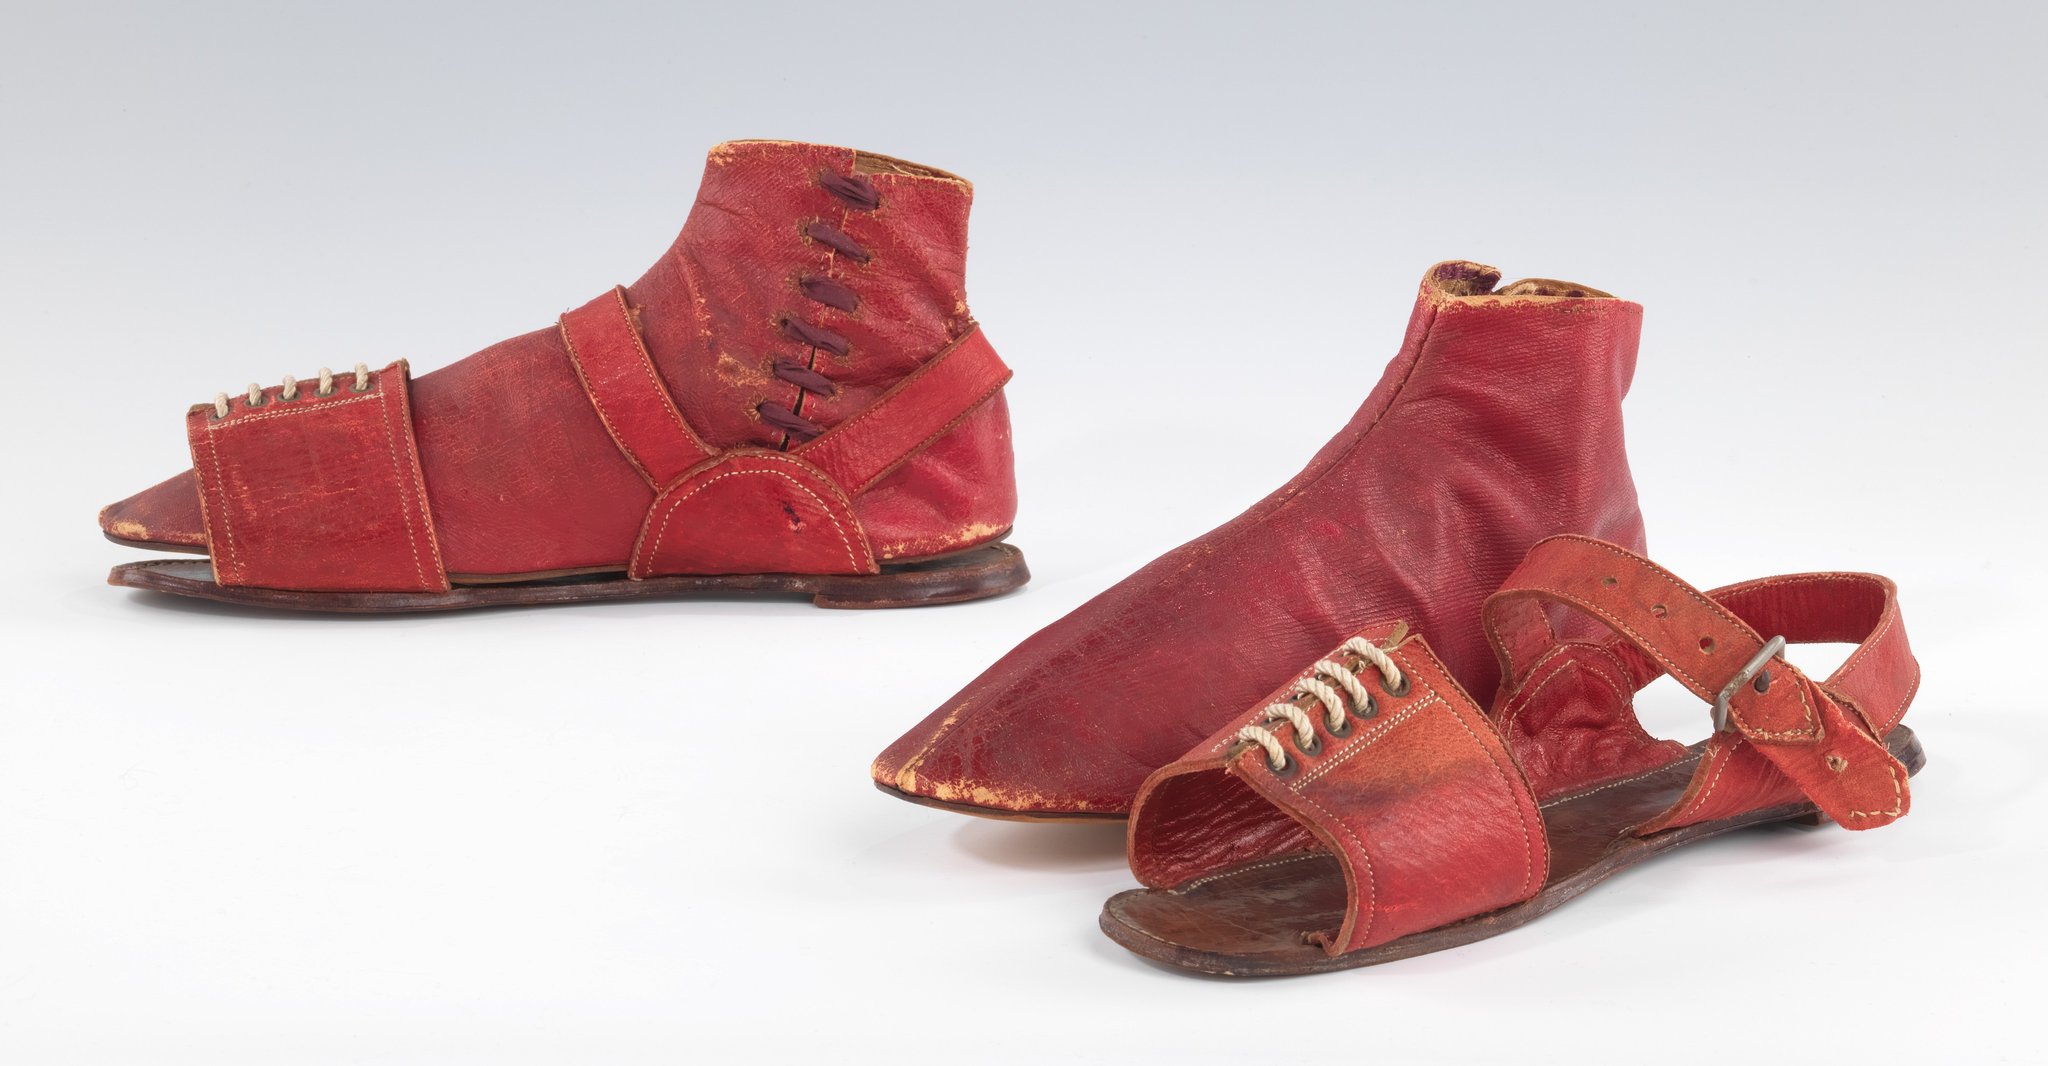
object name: accessory set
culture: american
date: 1825-1830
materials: leather